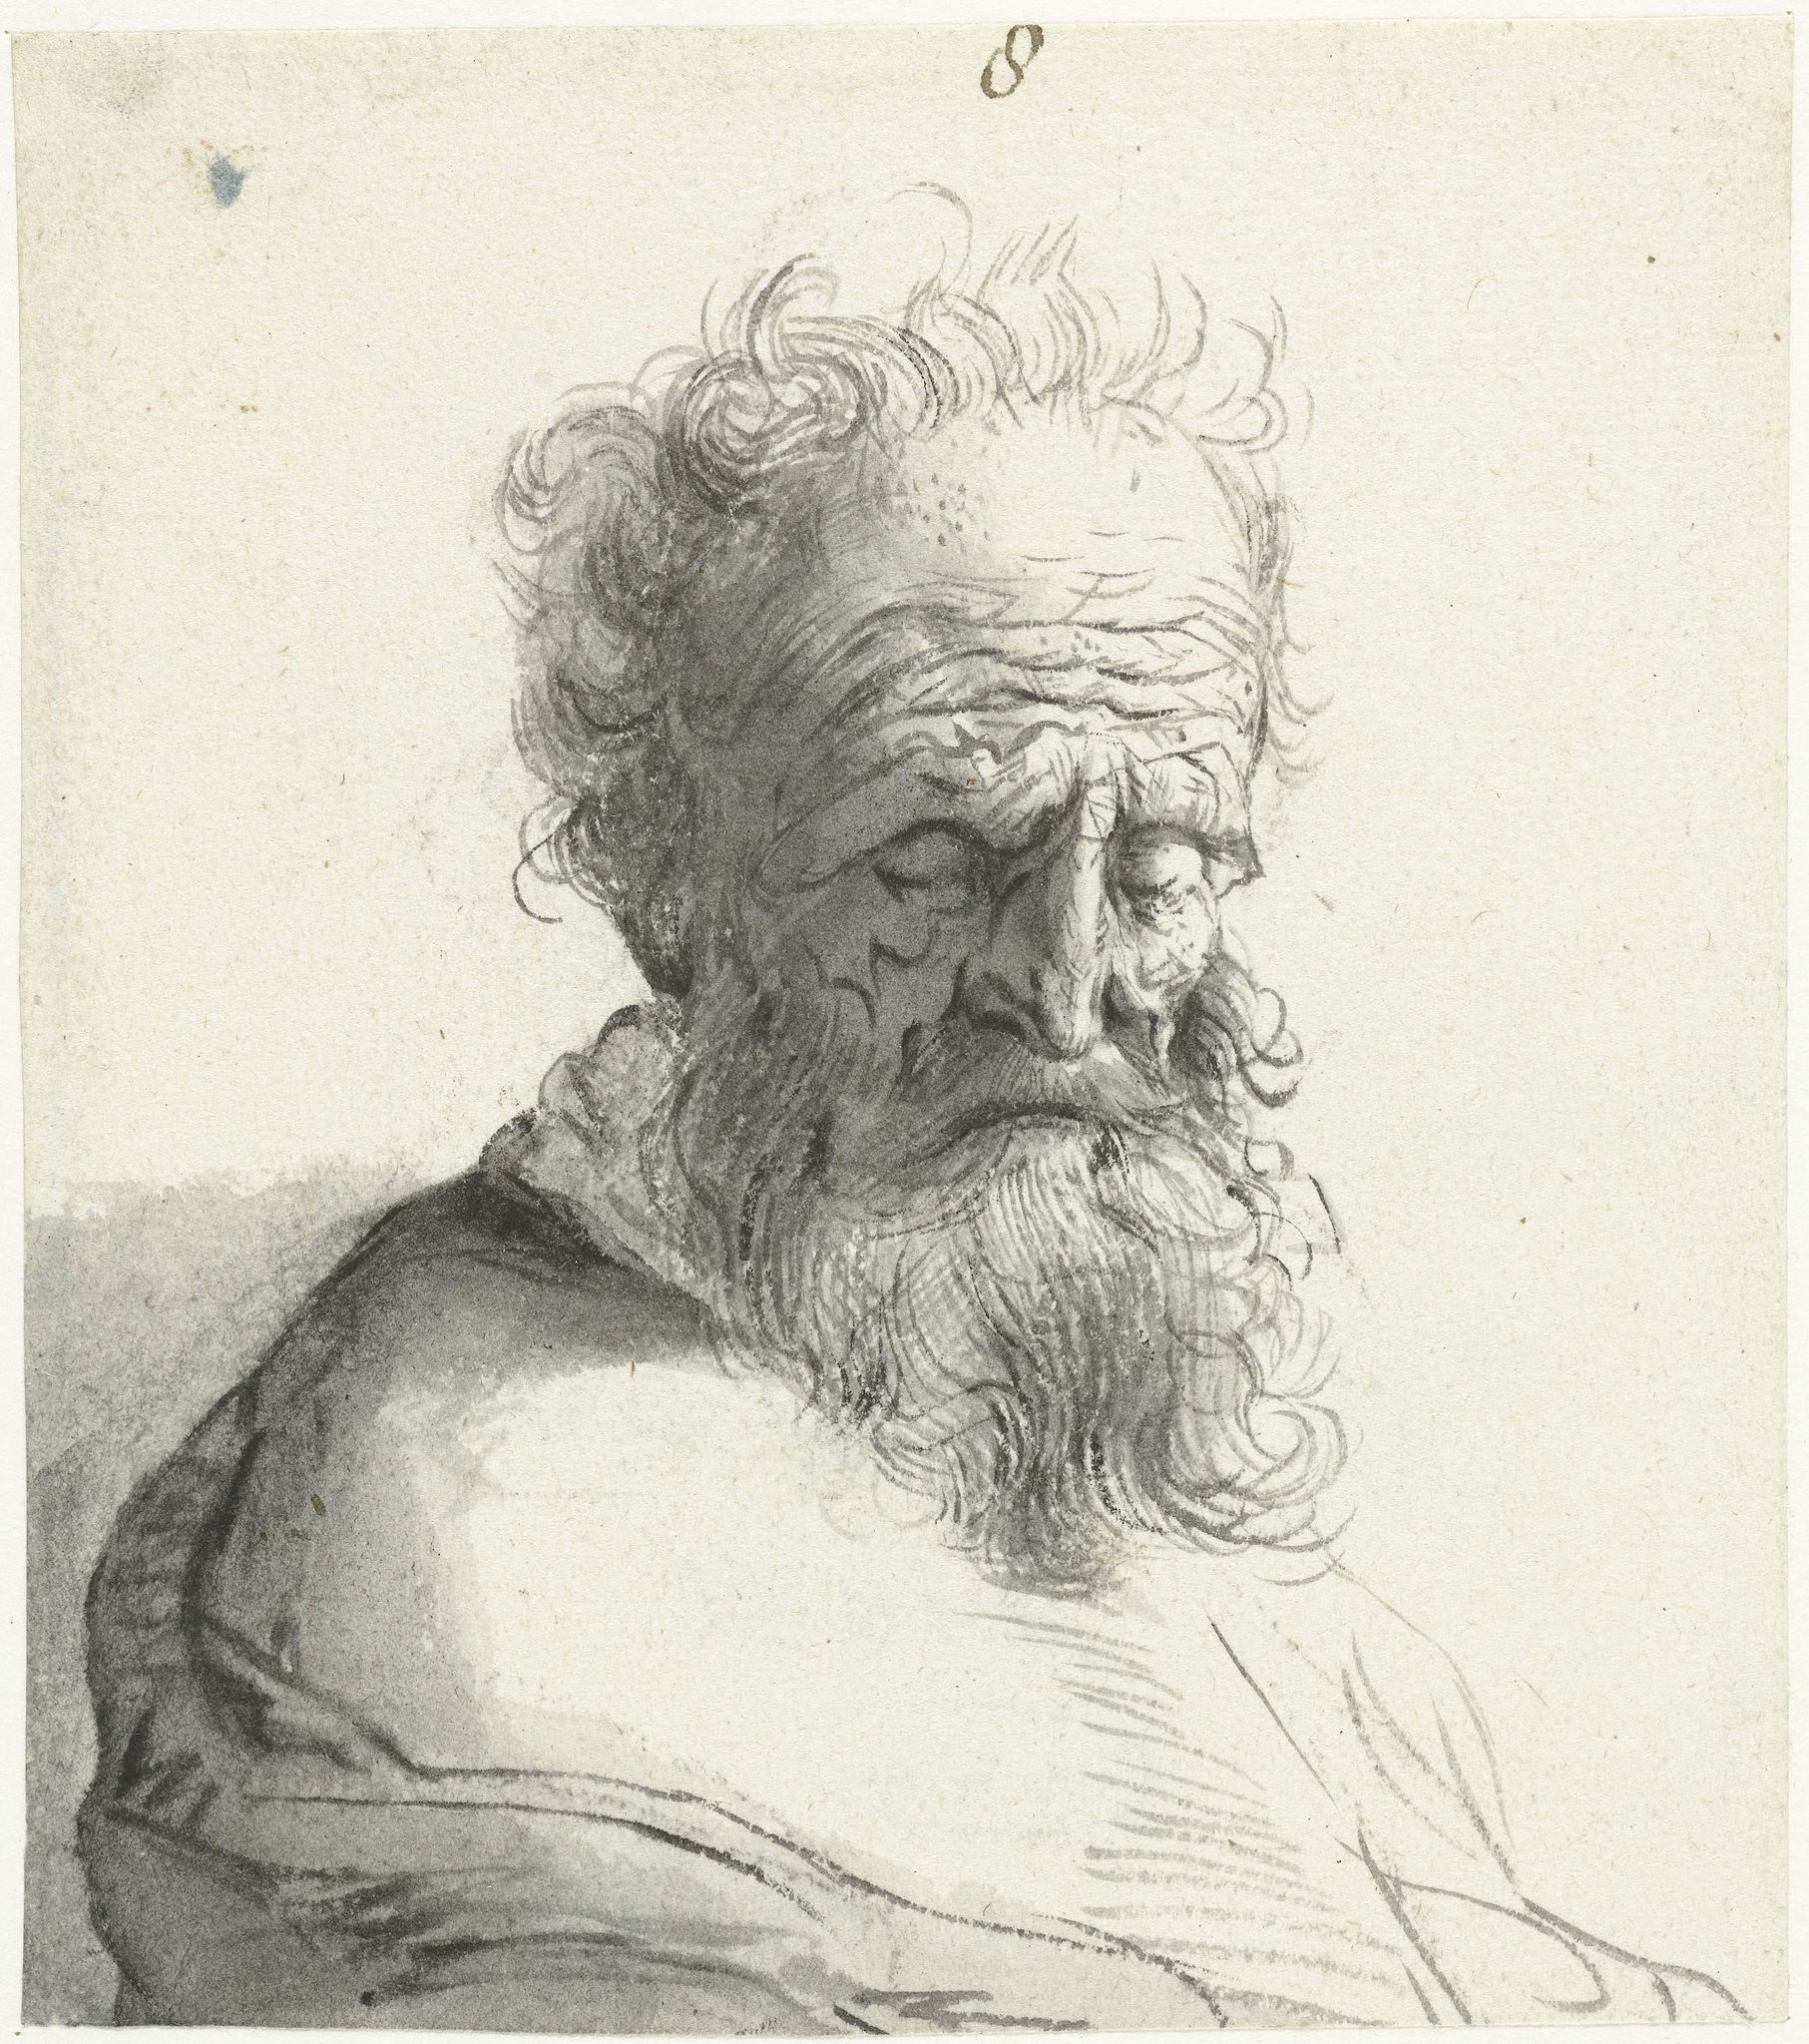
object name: drawing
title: Kop van een oude man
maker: moses ter borch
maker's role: draughtsman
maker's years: 1645-1667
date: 1659-1660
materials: chalk, ink, paper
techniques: brush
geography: zwolle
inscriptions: annotation: ‘naar Rembr./ B 260’